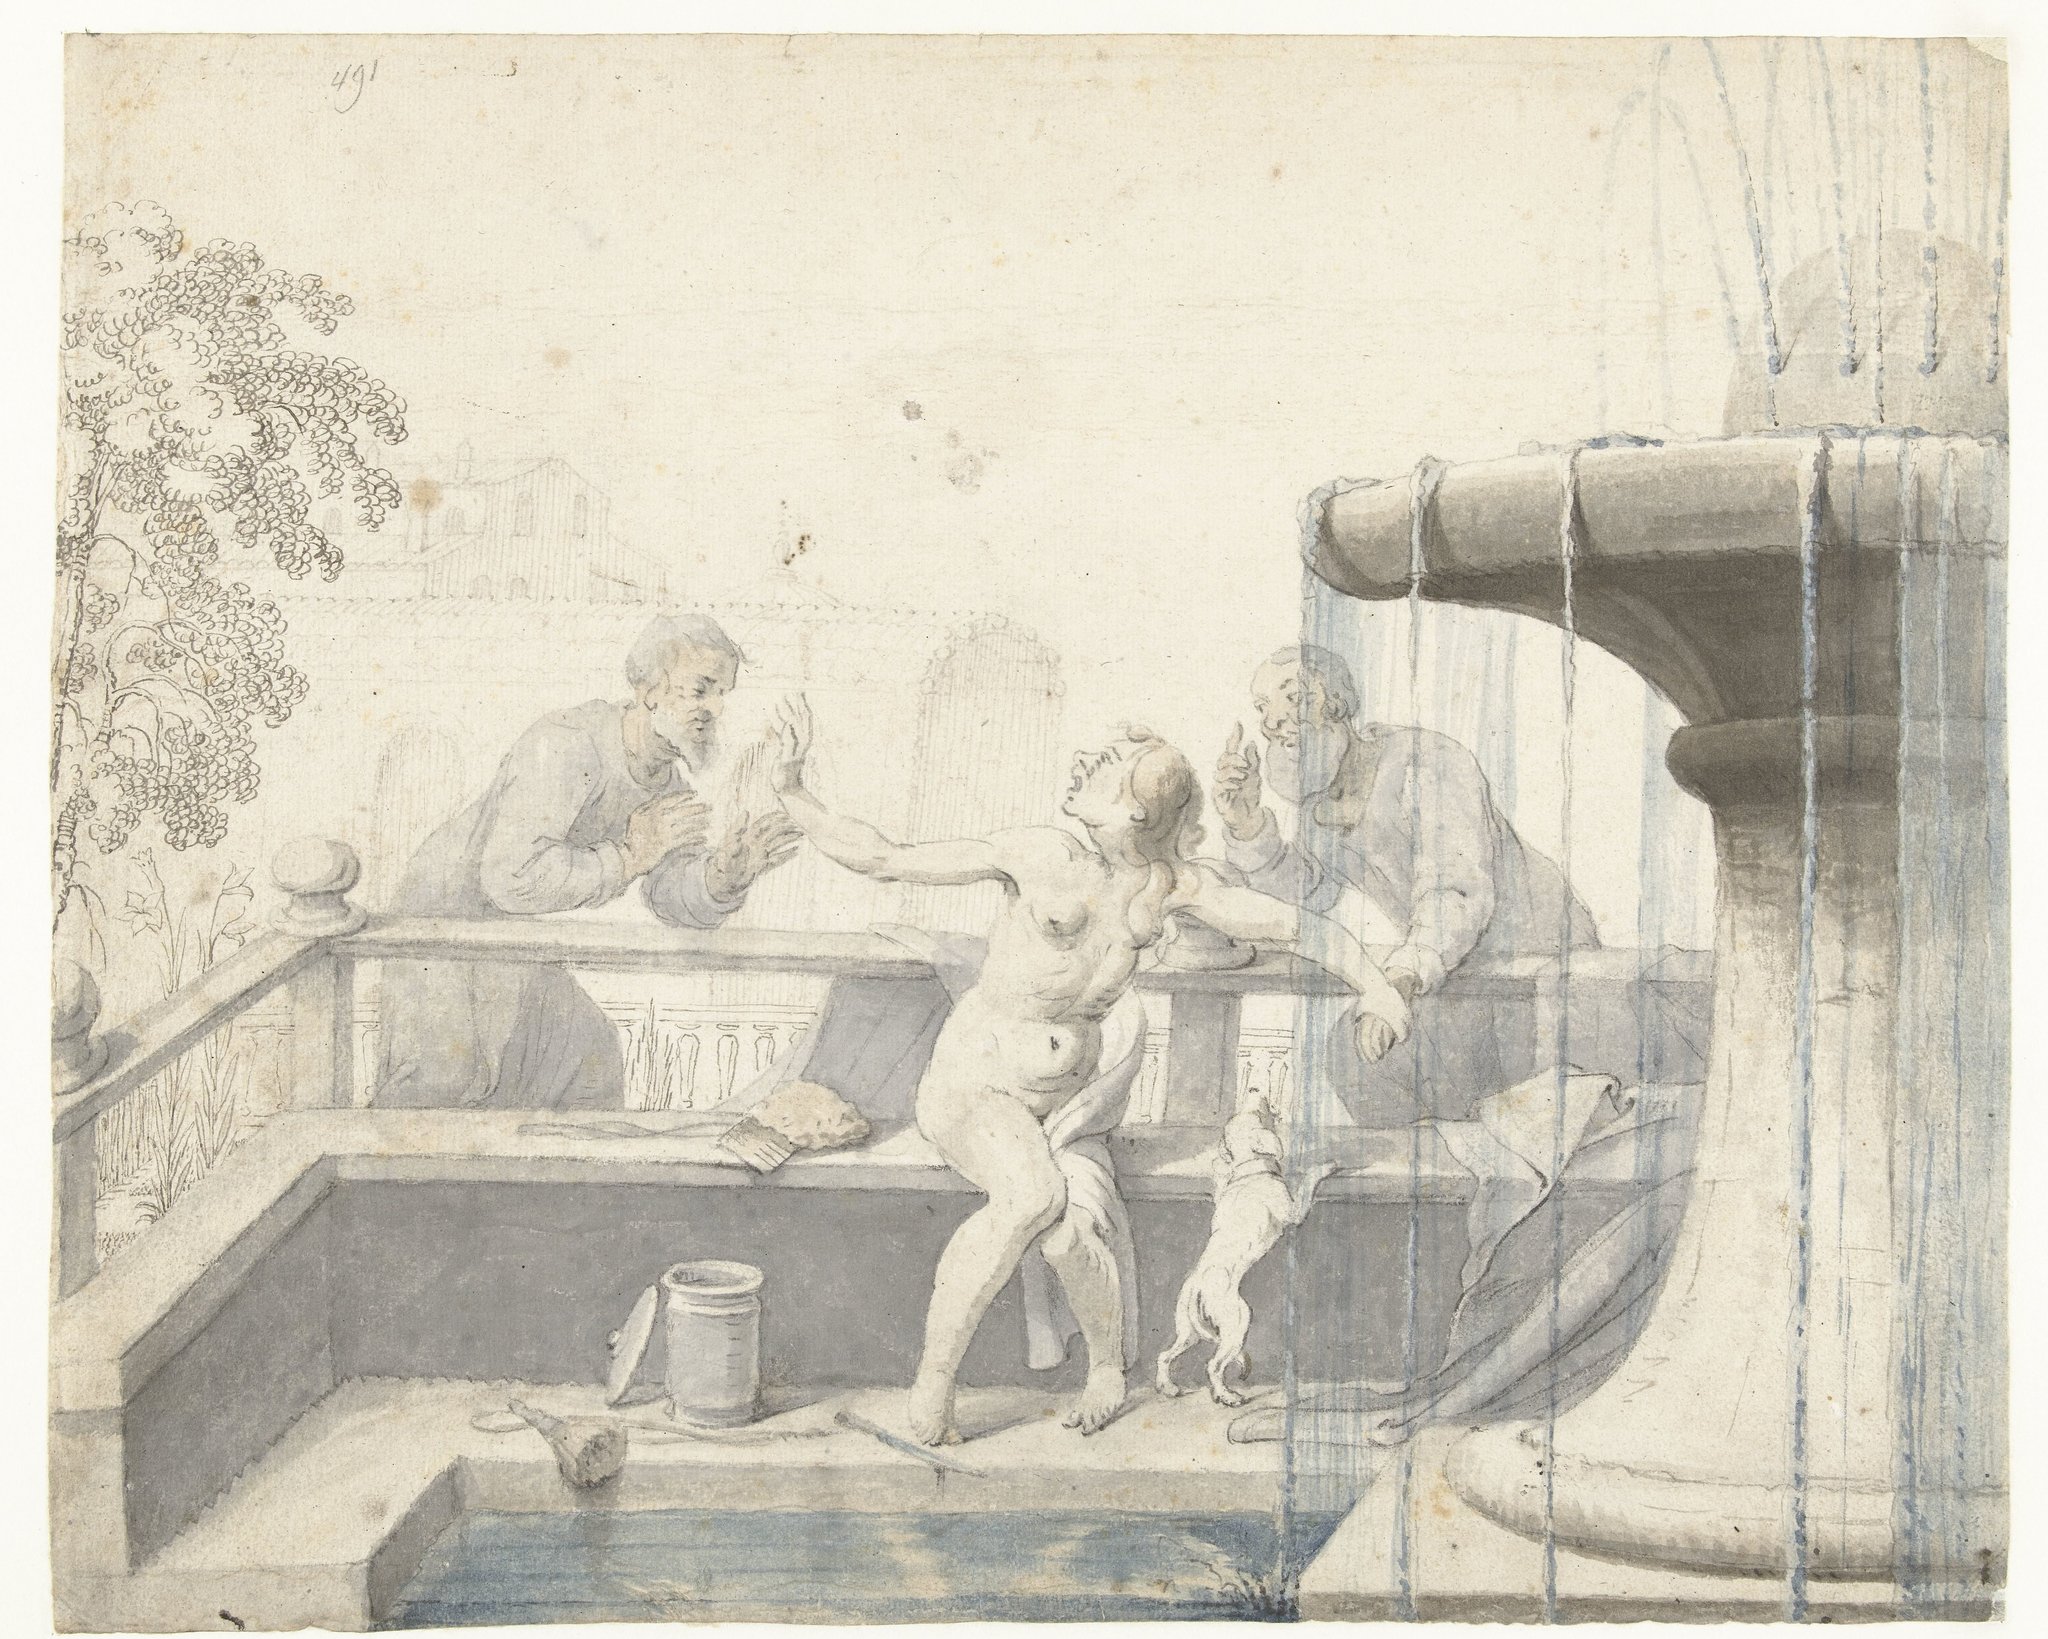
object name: watercolor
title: Suzanna en de ouderlingen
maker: gerard ter borch (i)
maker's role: draughtsman, print maker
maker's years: 1584-1662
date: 1620-1629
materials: chalk, ink, paper, watercolor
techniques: brush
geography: zwolle